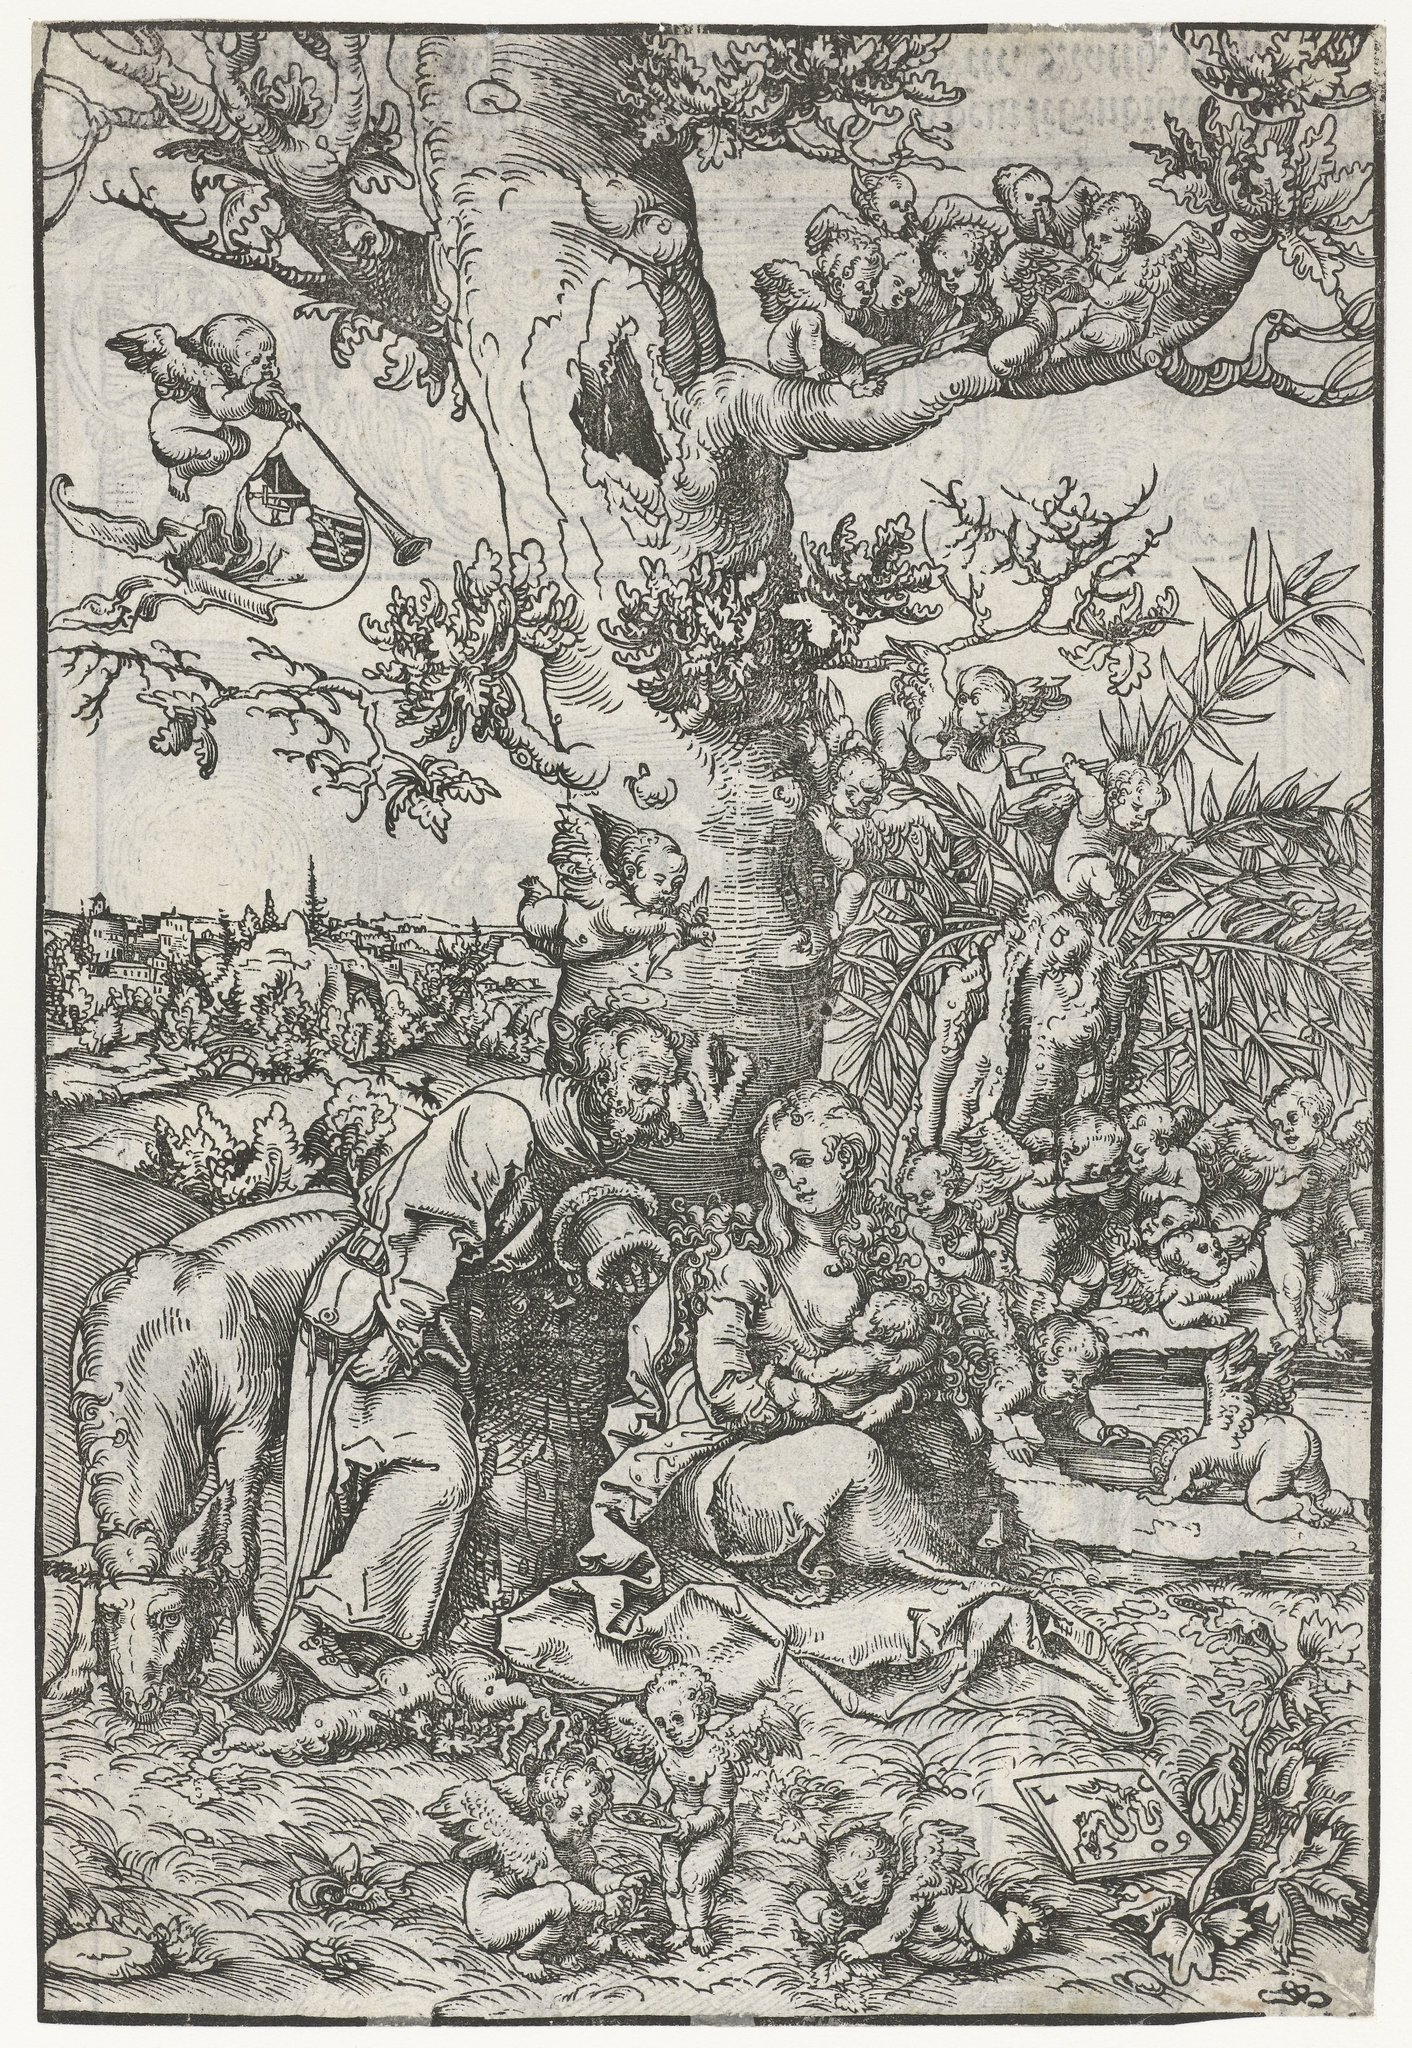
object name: print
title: Rest on the Flight into Egypt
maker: lucas cranach (i)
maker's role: draughtsman, print maker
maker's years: 1472-1553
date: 1509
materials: paper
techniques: woodcut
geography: germany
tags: rest on the flight into egypt, cupids: 'amores', 'amoretti', 'putti'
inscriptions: collector's mark: Lugt 240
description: Maria met Christus en Jozef rusten bij een boom tijdens hun vlucht naar Egypte. Jozef houdt de grazende ezel aan een leidsel vast. Om hen heen zitten overal putti. Een putto blaast op een bazuin met een vaandel waarop twee kleine schilden met het keurvorstelijk en hertogelijk wapen van Saksen staan.